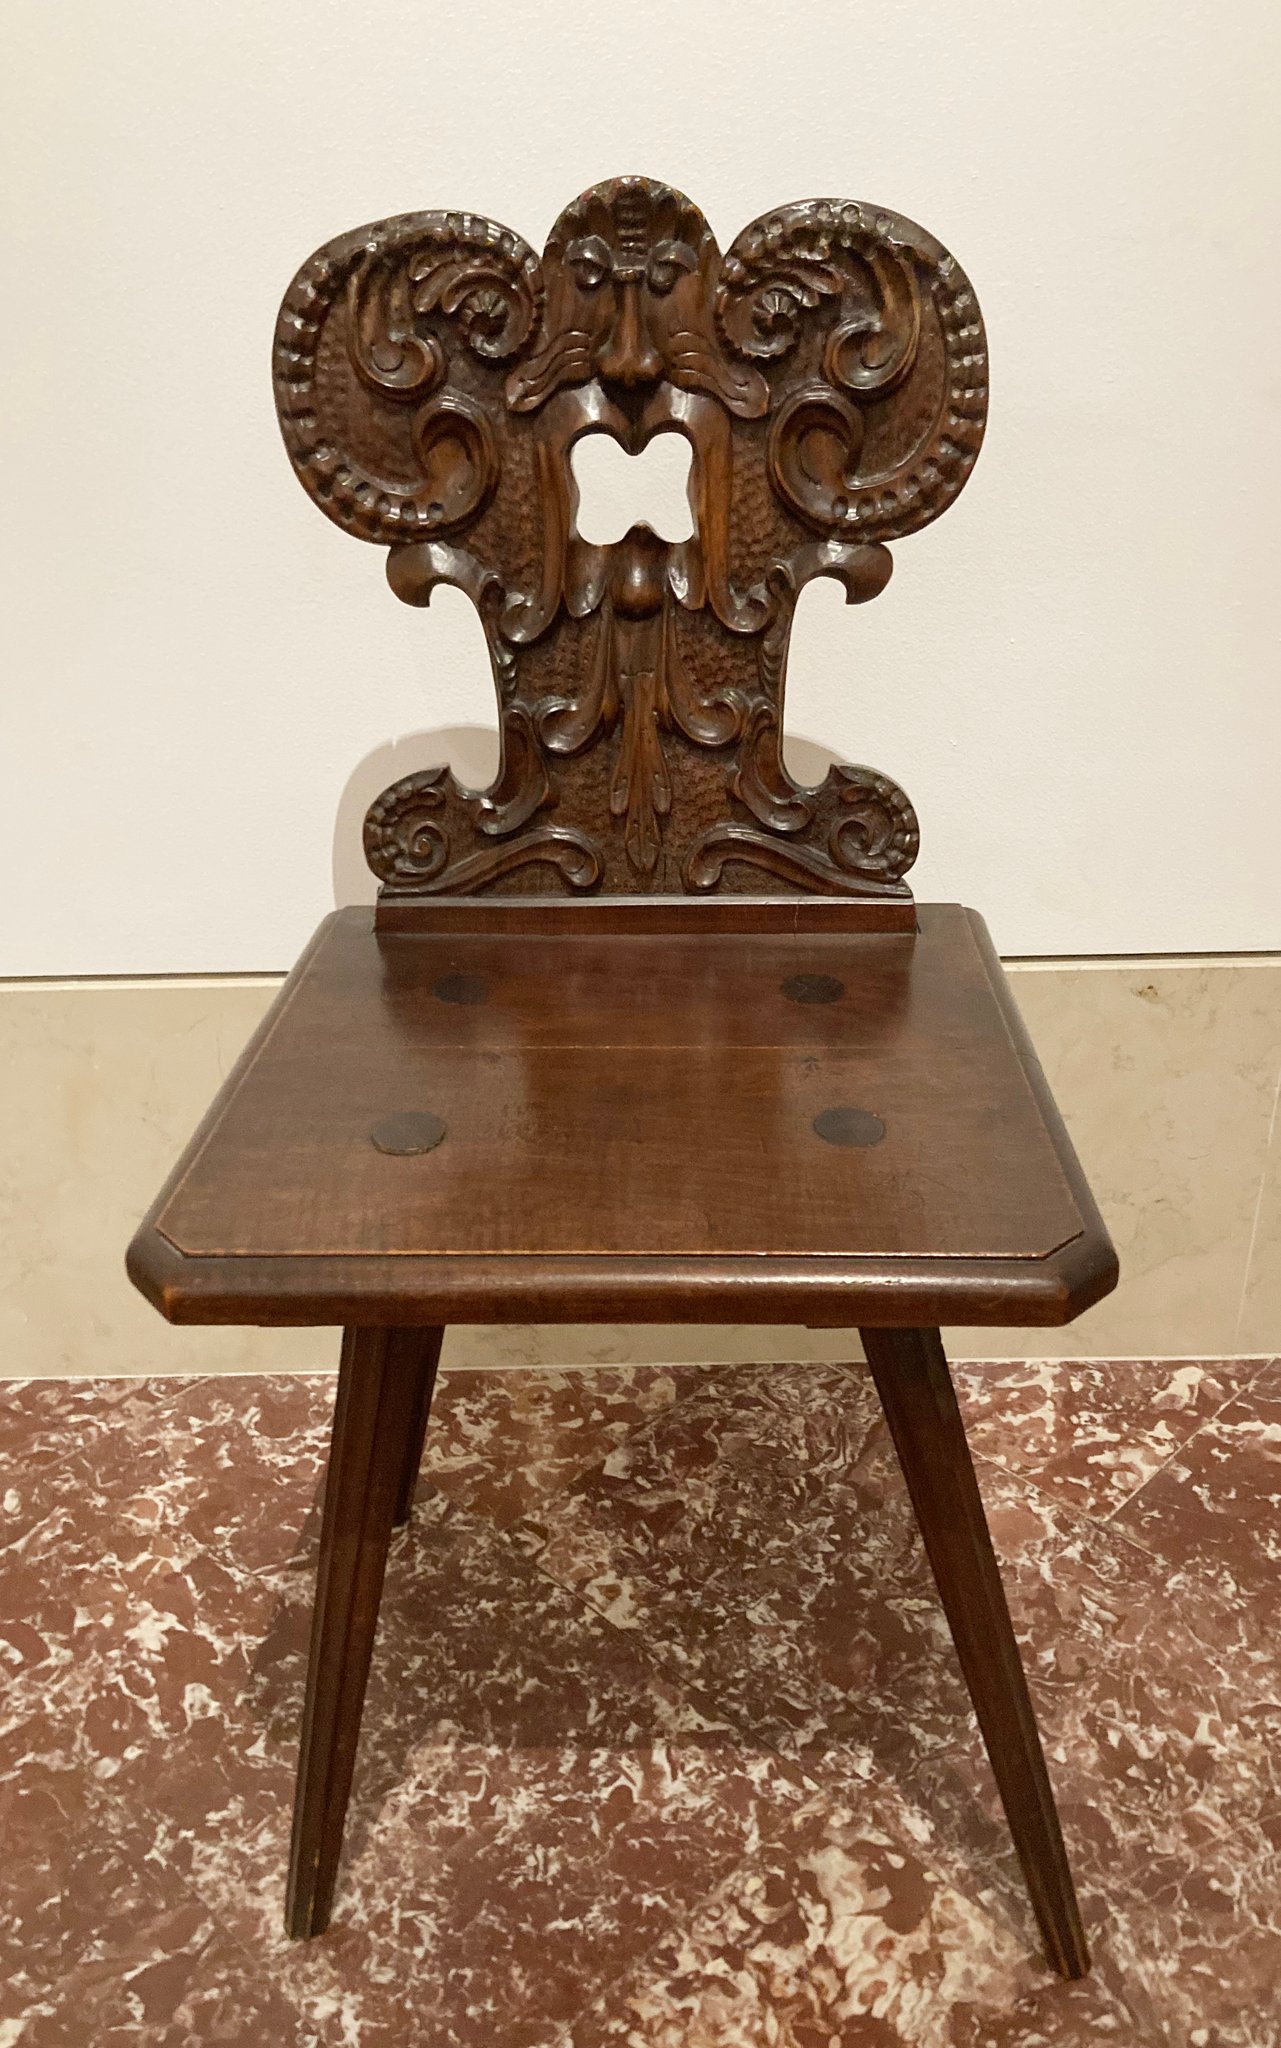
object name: chair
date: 1634-1666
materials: wood